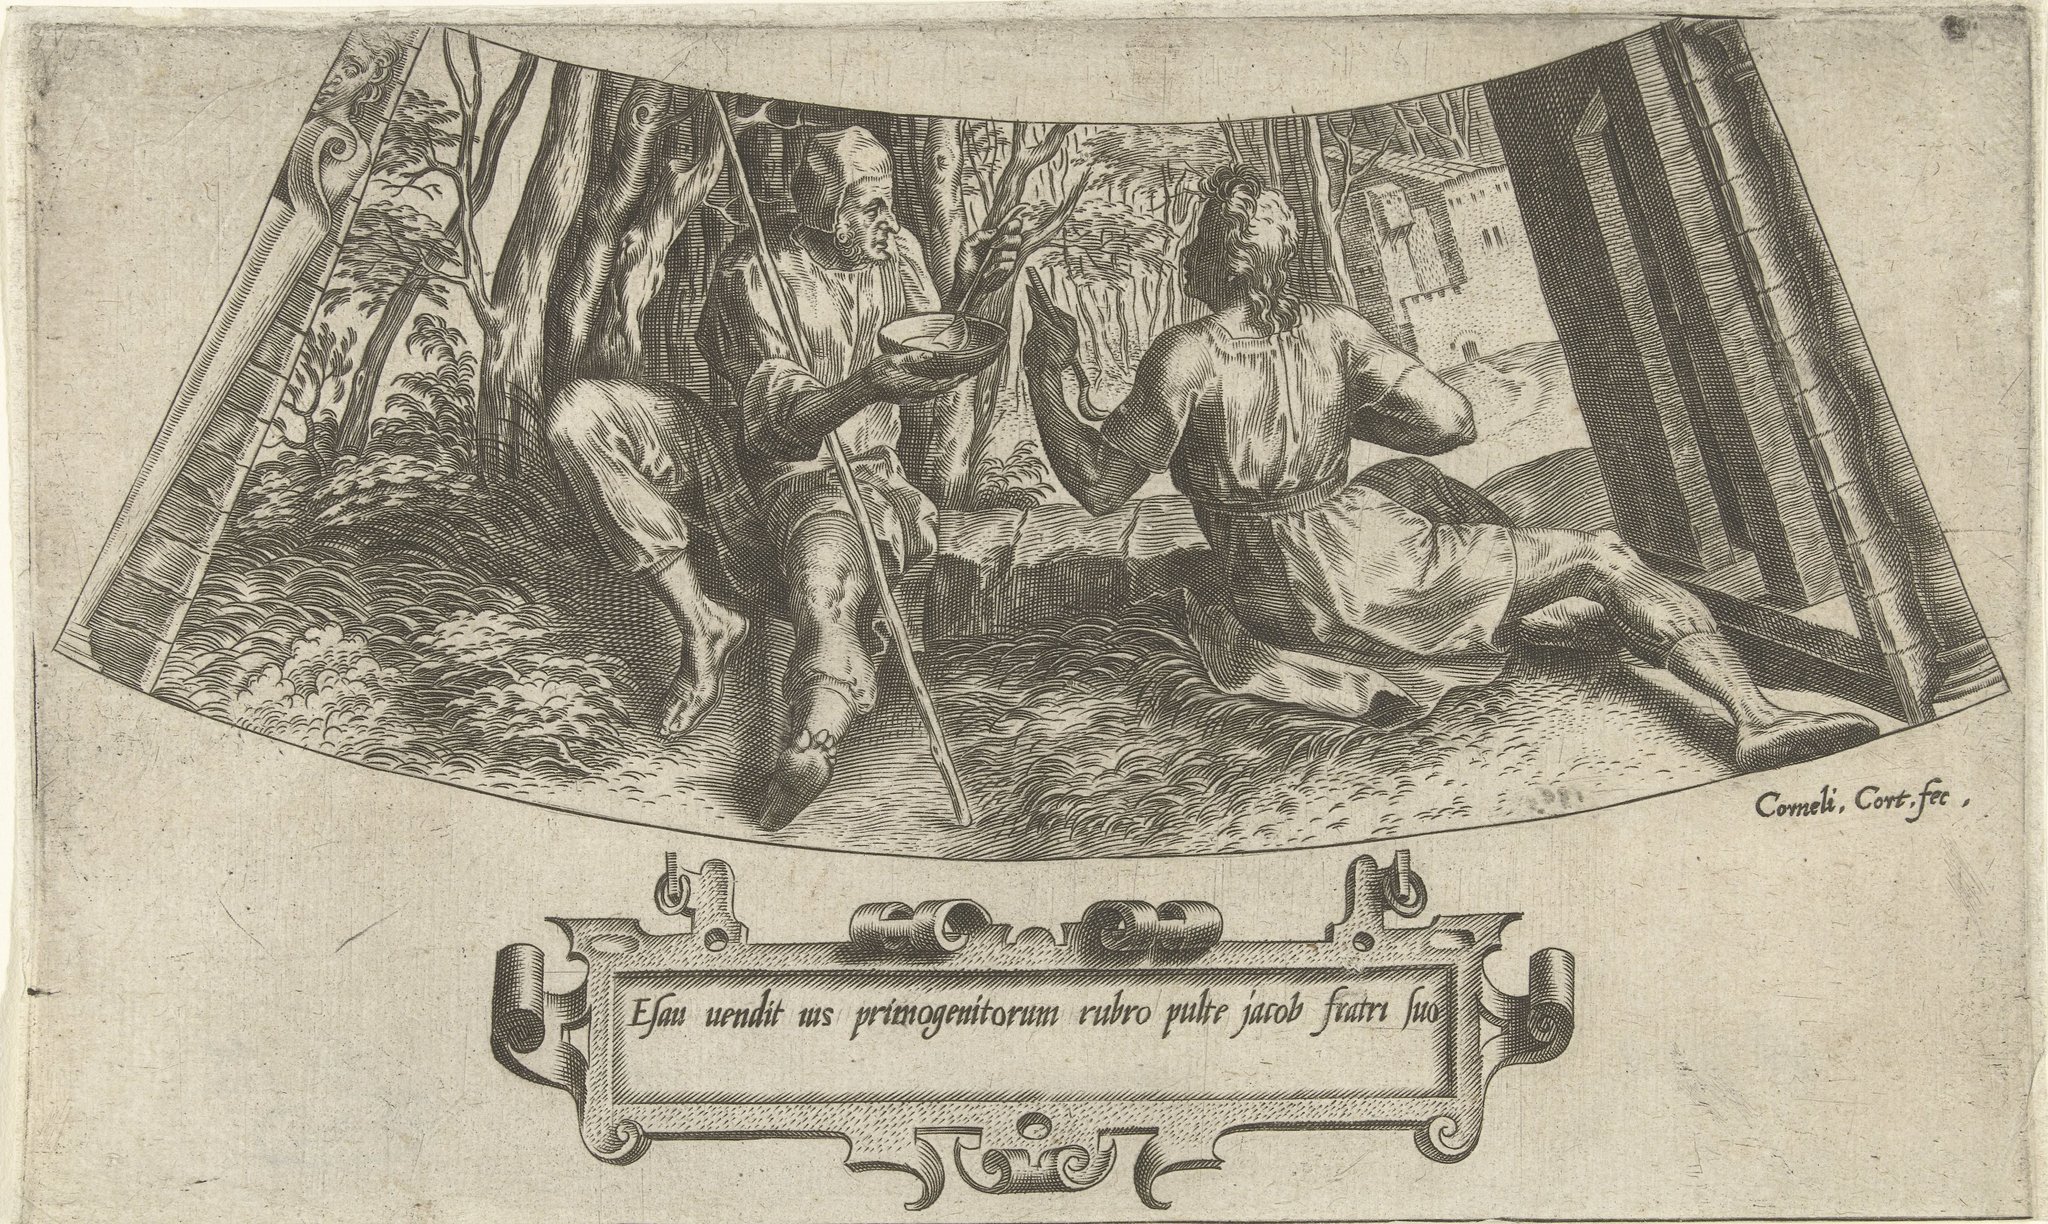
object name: print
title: De geschiedenis van Jakob en Esau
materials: paper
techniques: engraving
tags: ornament ~ cartouche, cradle, crib, birth of the twins: jacob clutches esau's heel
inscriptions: caption: ‘Esau vendit ius primogenitorum rubro pulte jacob fratri suo.’, collector's mark: Lugt 2228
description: Ornament voor een schotelrand. Bovenste helft: Jakob en Esau zitten voor een huis op de grond. Esau eet zijn bord linzensoep, waarmee hij zijn eerstgeboorterecht aan zijn broer Jakob verkoopt. Onderschrift in Latijn in cartouche.